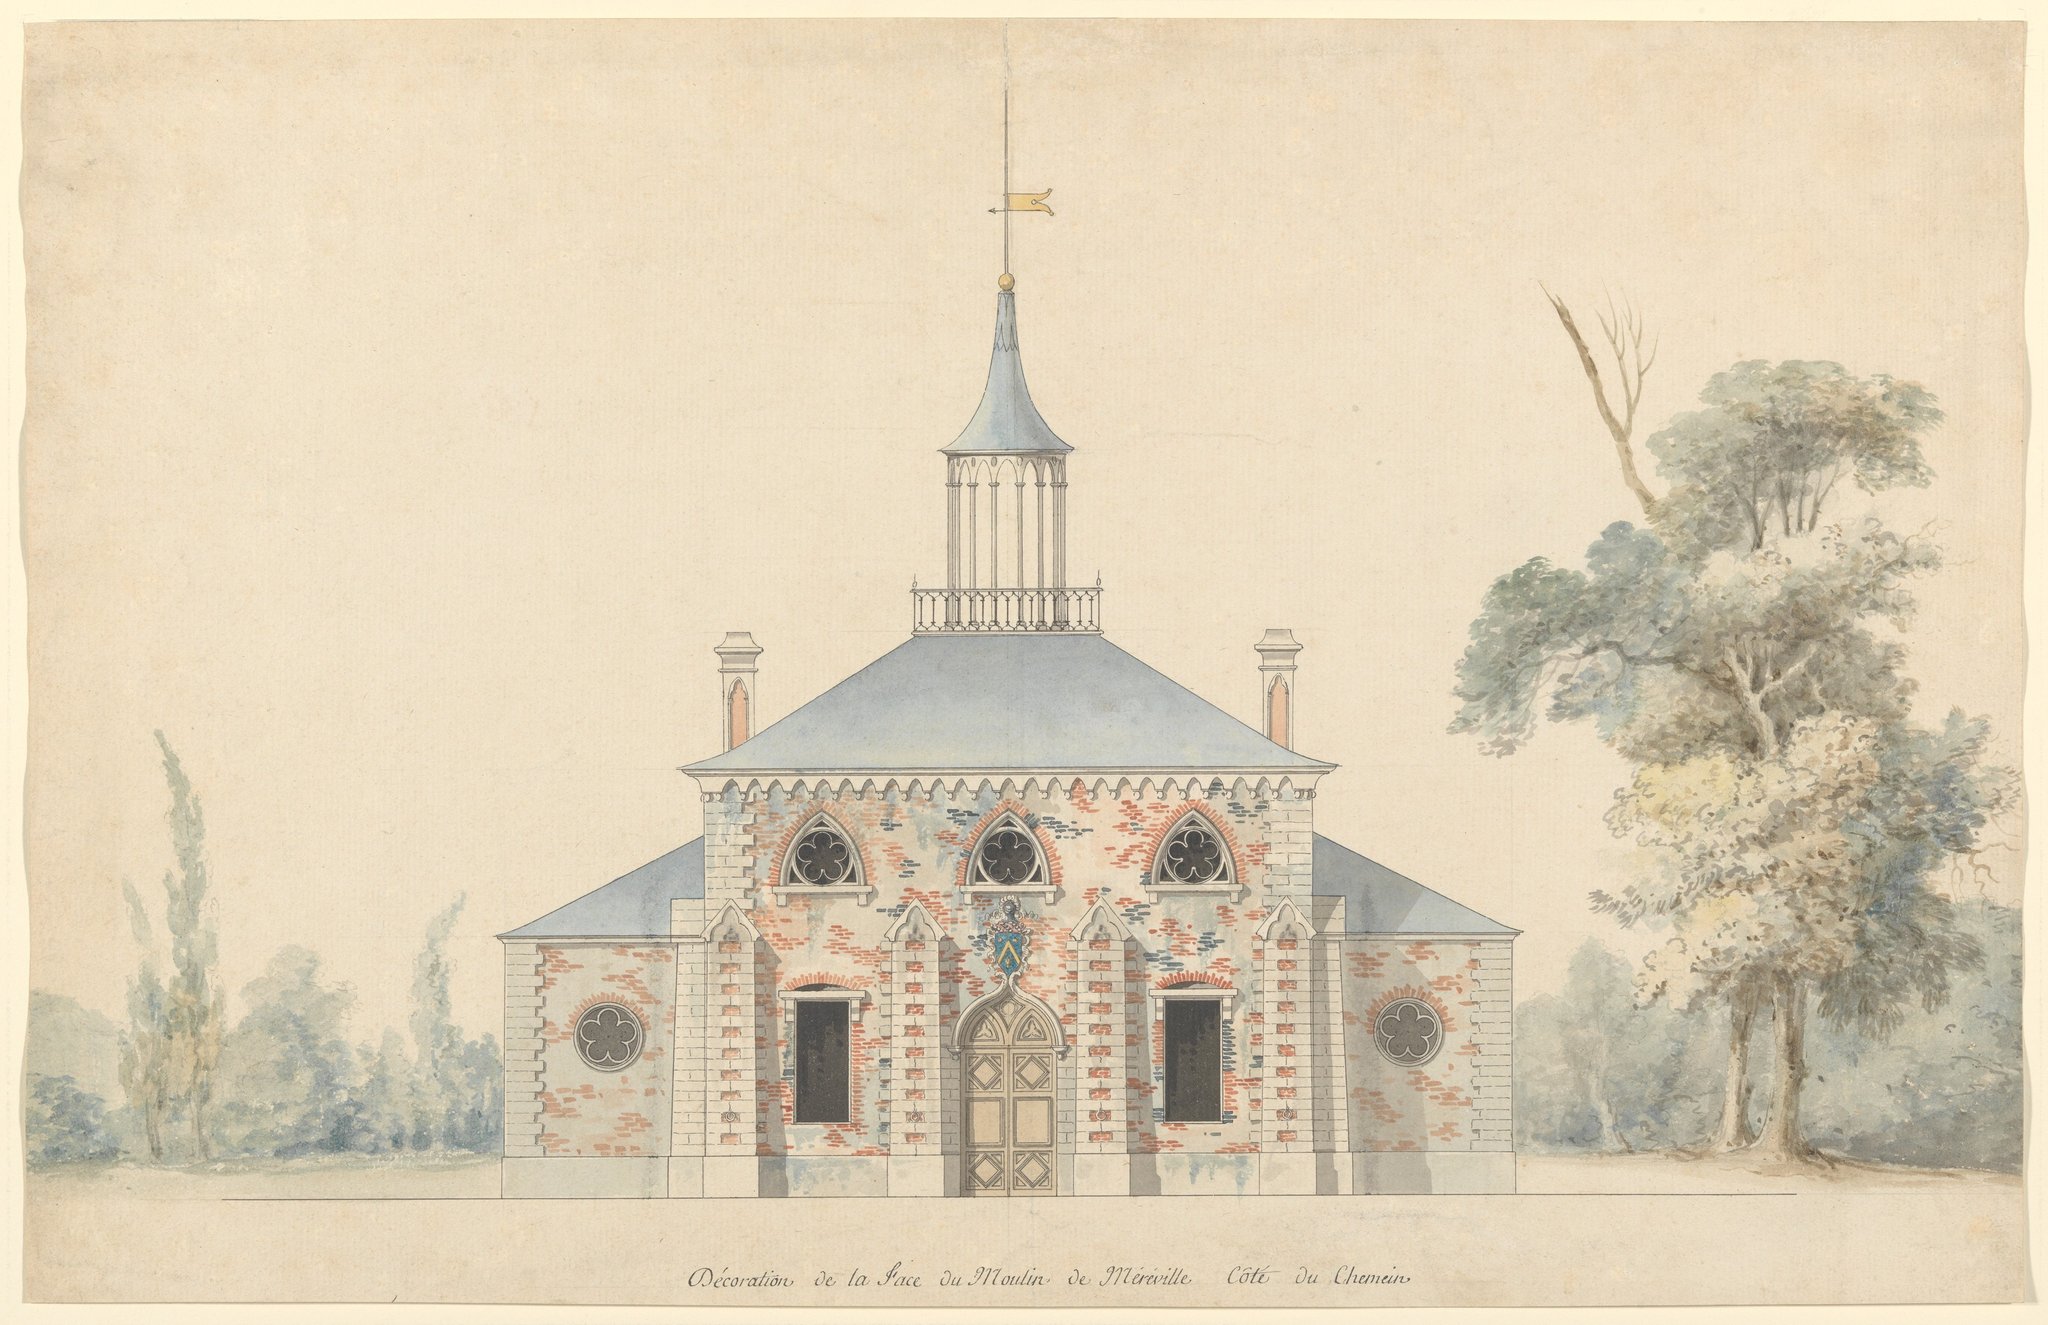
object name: drawing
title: An Elevation for the Projected Mill at Méréville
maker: françois joseph belanger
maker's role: artist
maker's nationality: french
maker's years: 1744-1818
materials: graphite, ink, watercolor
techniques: pen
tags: buildings,doors,trees